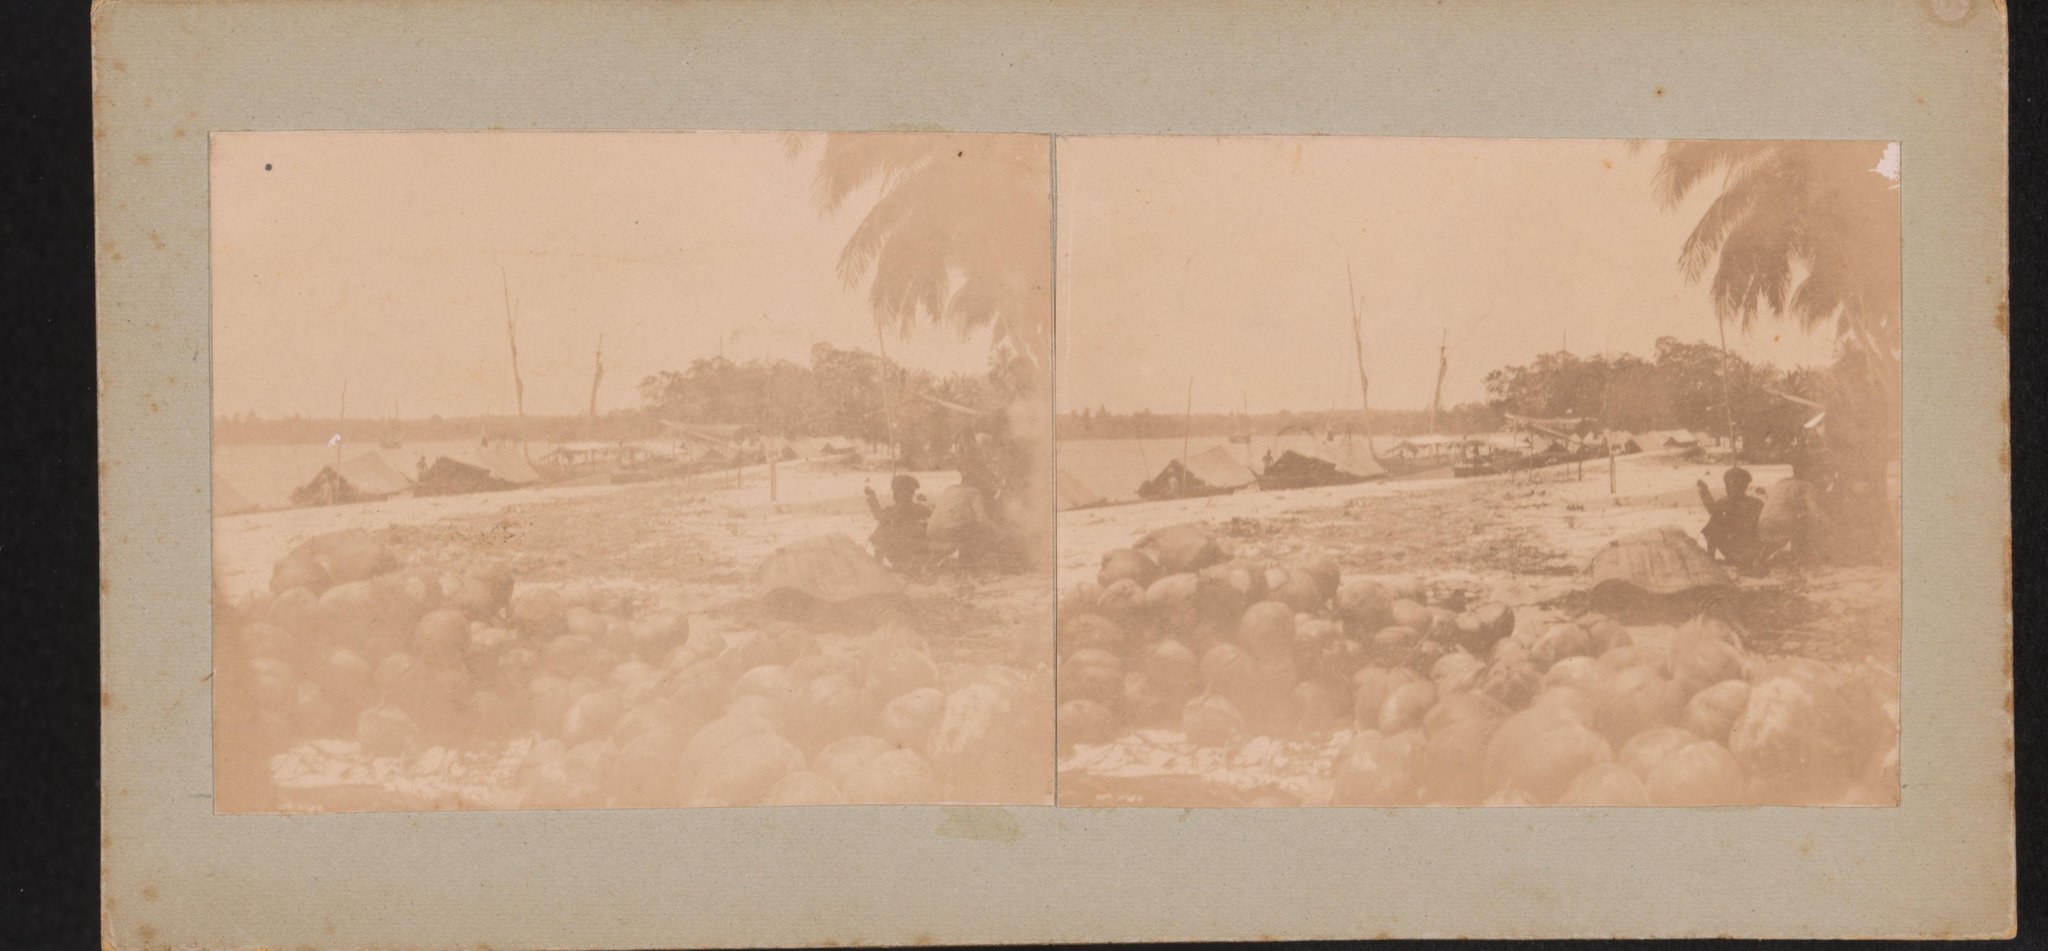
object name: stereograph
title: Strand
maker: robert julius boers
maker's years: 1867-1932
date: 1900-1922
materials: cardboard, photographic support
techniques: gelatin silver print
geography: bangka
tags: robert julius boers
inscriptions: inscription: ‘Koealla Batoe Boessa’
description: Strandgezicht met overdekte bootjes en op de voorgrond een stapel kokosnoten, waarschijnlijk op Banka. Onderdeel van een groep stereofoto's van Robert Julius Boers, chef van het staatsbedrijf de Banka-tinwinning op Banka, uit de periode ca. 1900-1922.